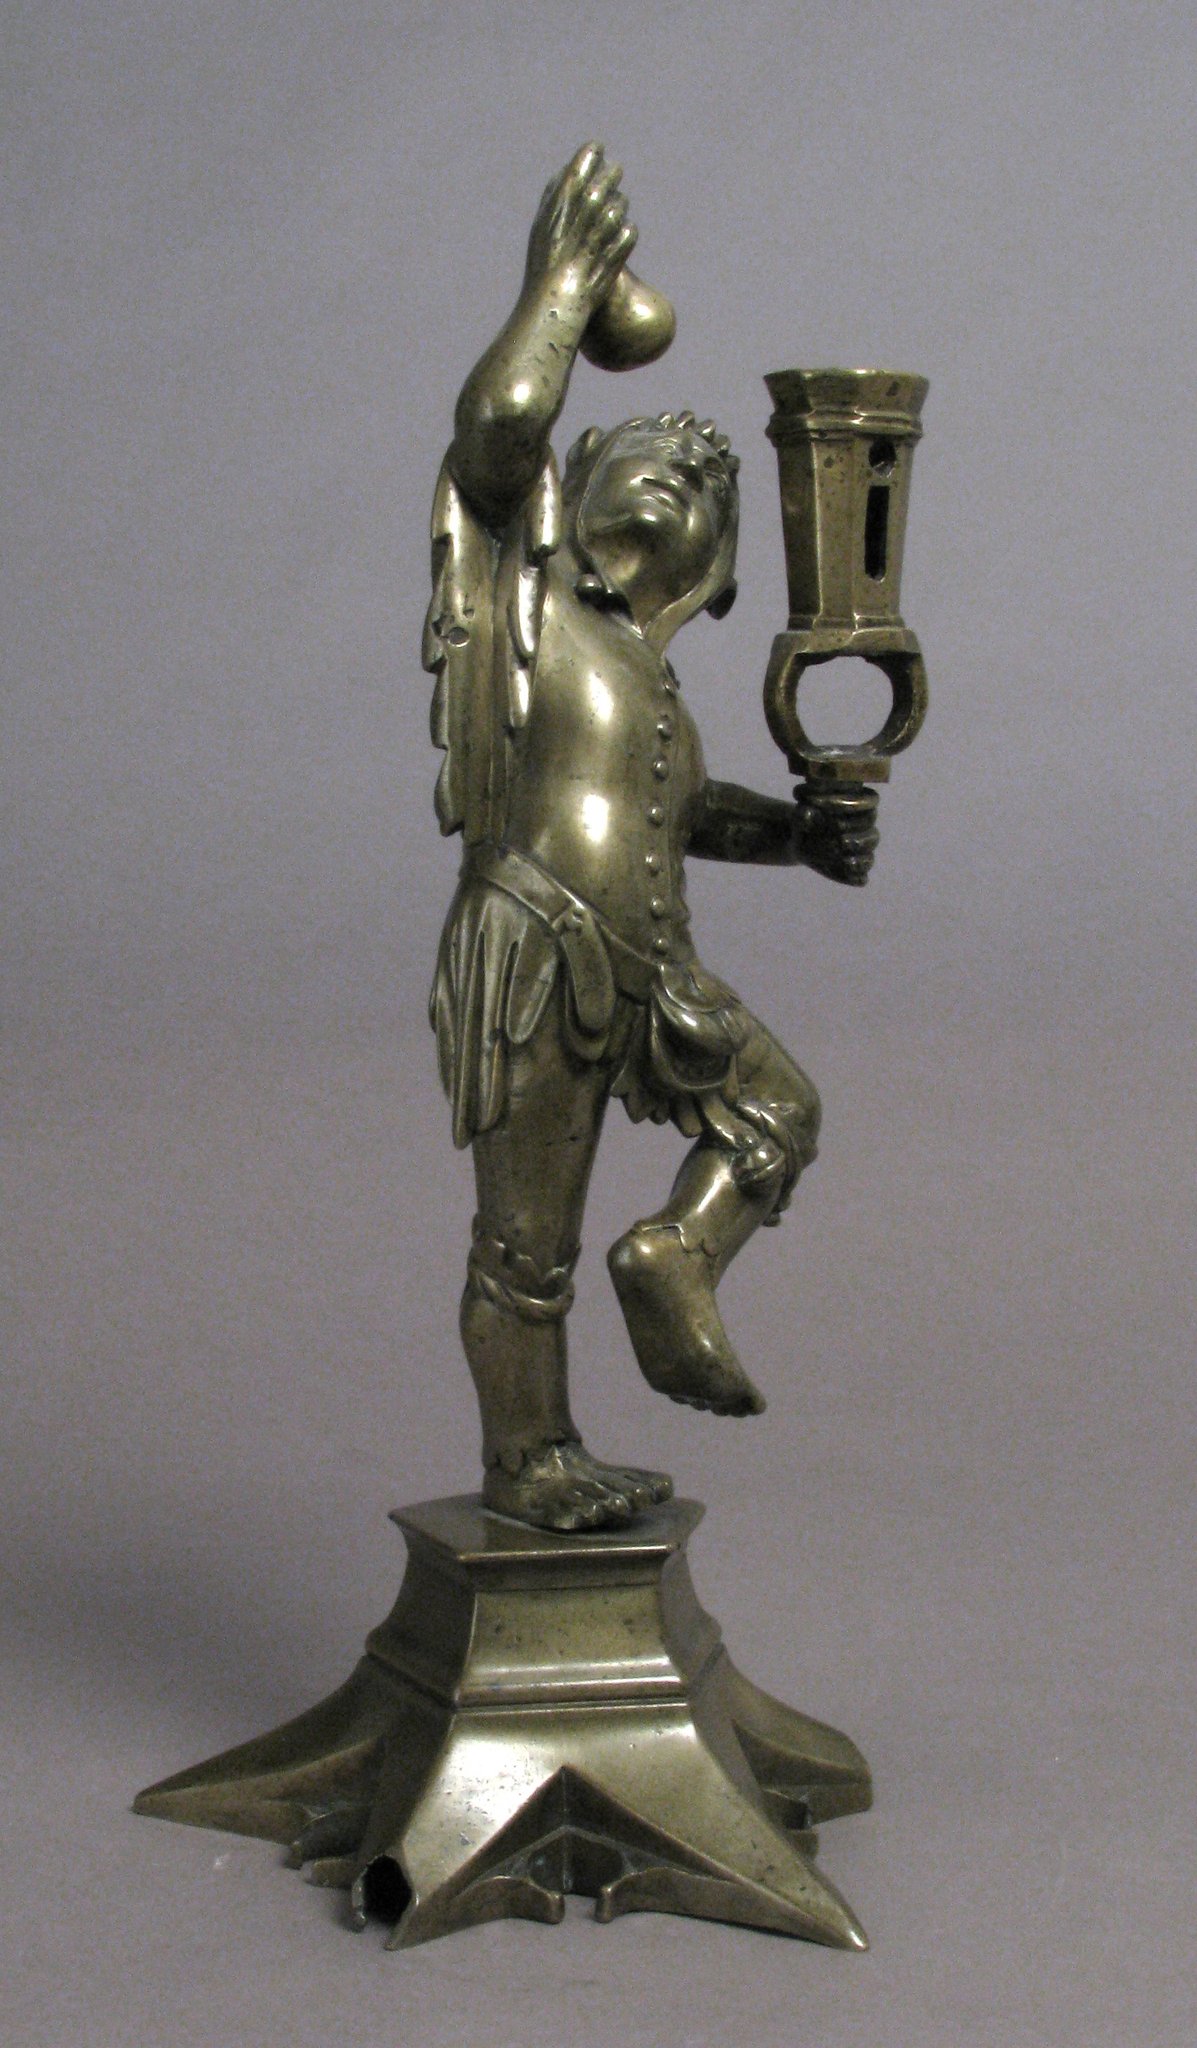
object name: candlestick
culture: south netherlandish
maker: jehan aert van tricht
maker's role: artist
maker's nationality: netherlandish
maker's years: 1492-1501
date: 1500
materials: brass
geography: maastricht or xanten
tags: men